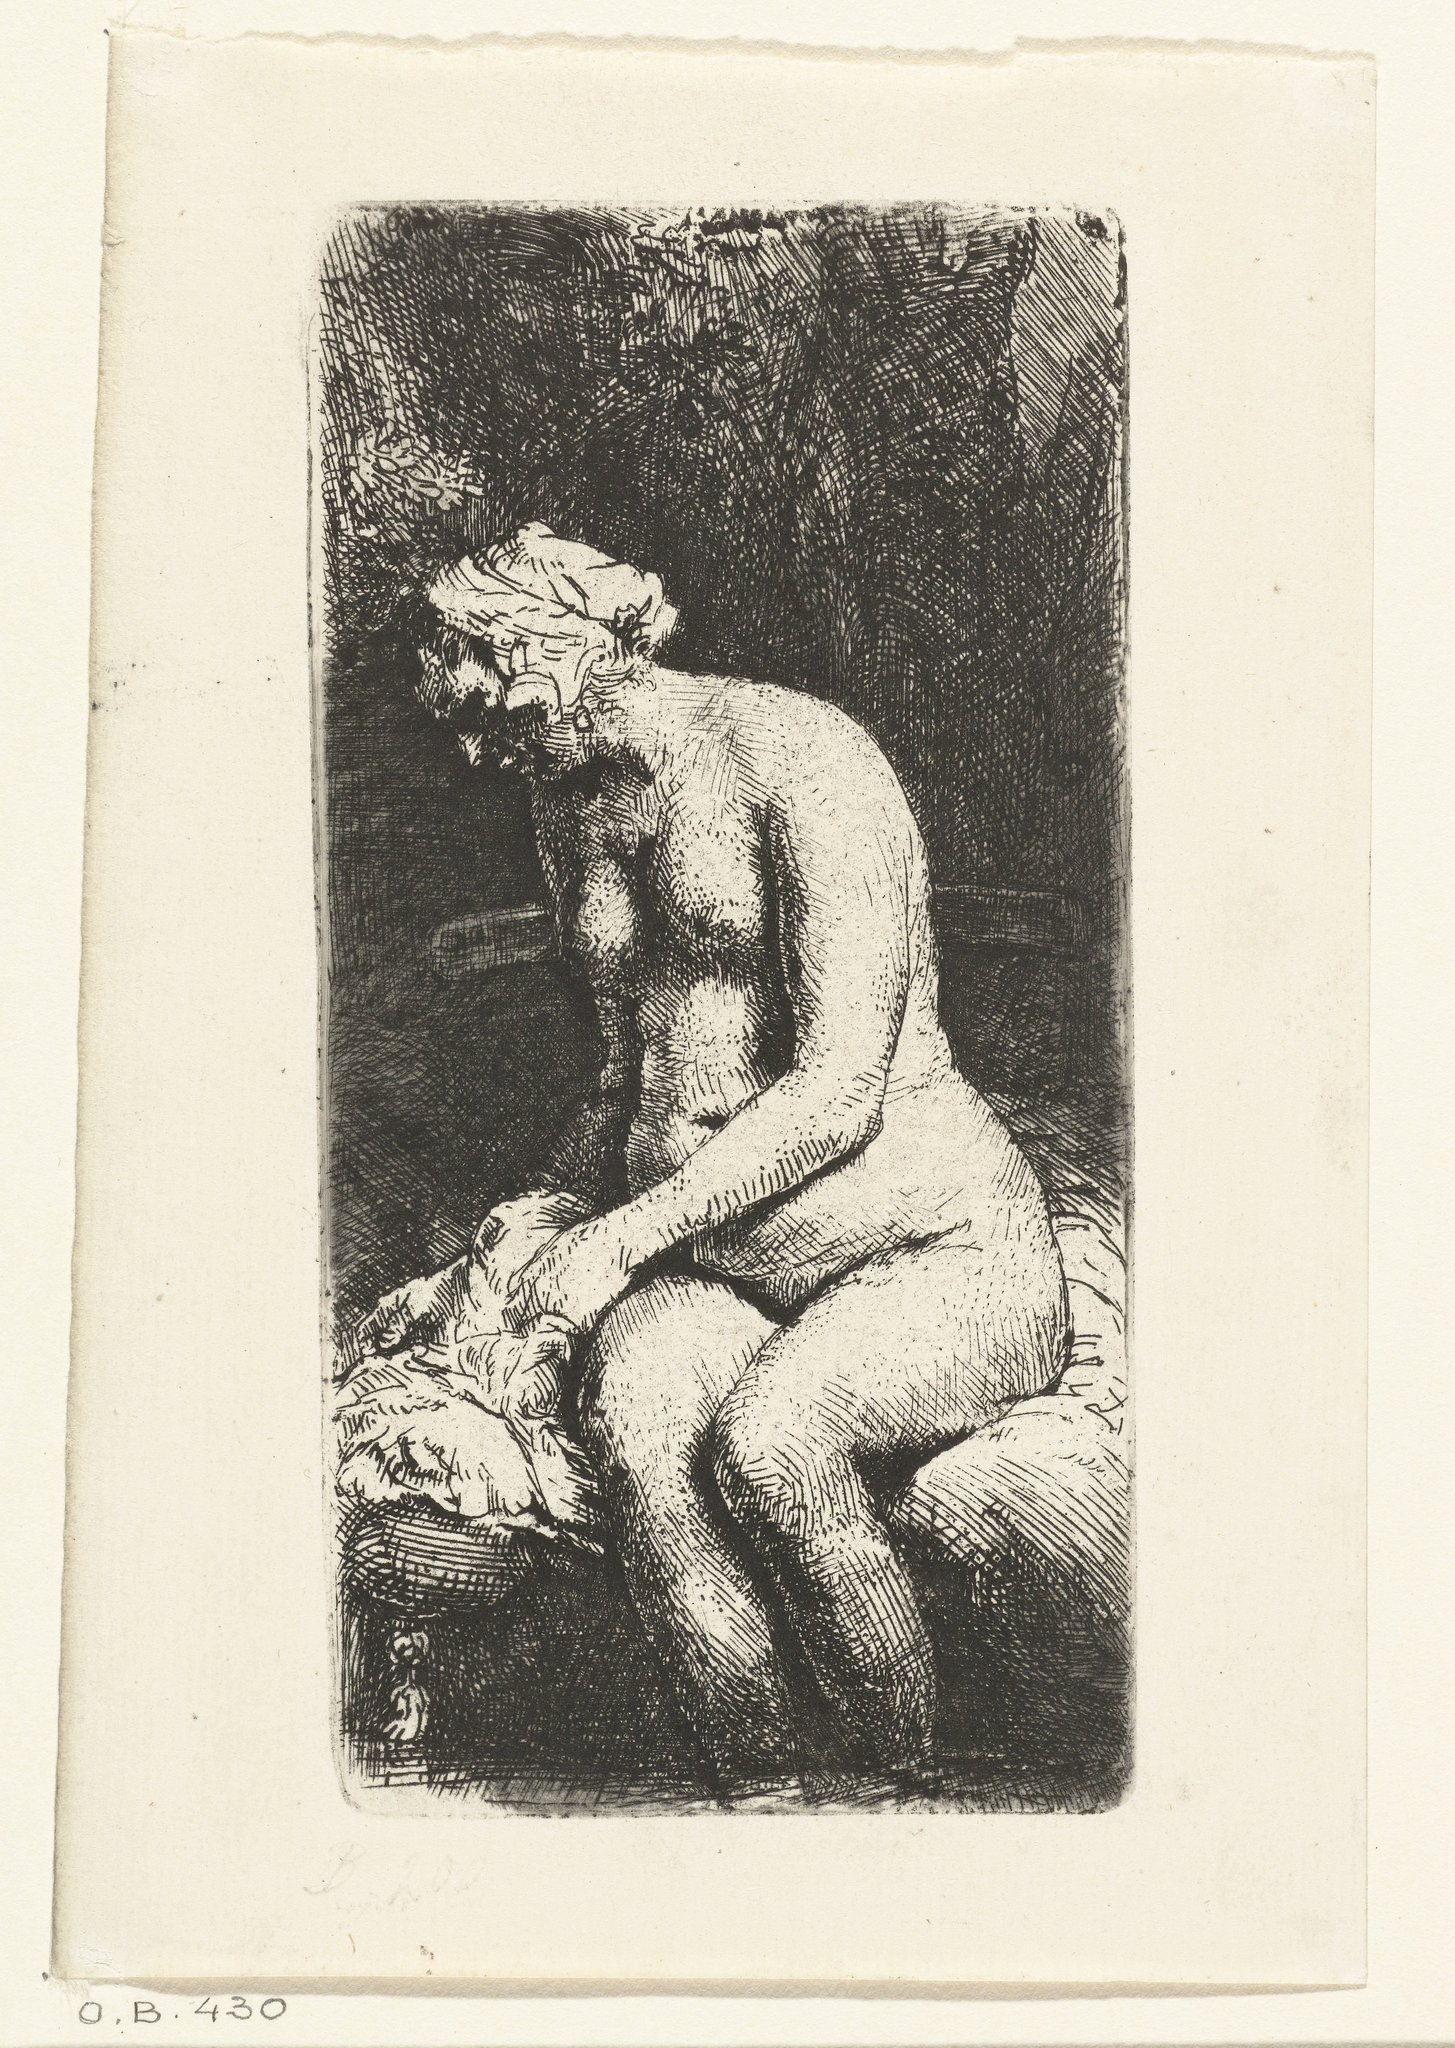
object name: print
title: Woman bathing her feet at a brook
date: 1658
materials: paper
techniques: drypoint, etching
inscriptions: inscription: ‘Coppier’